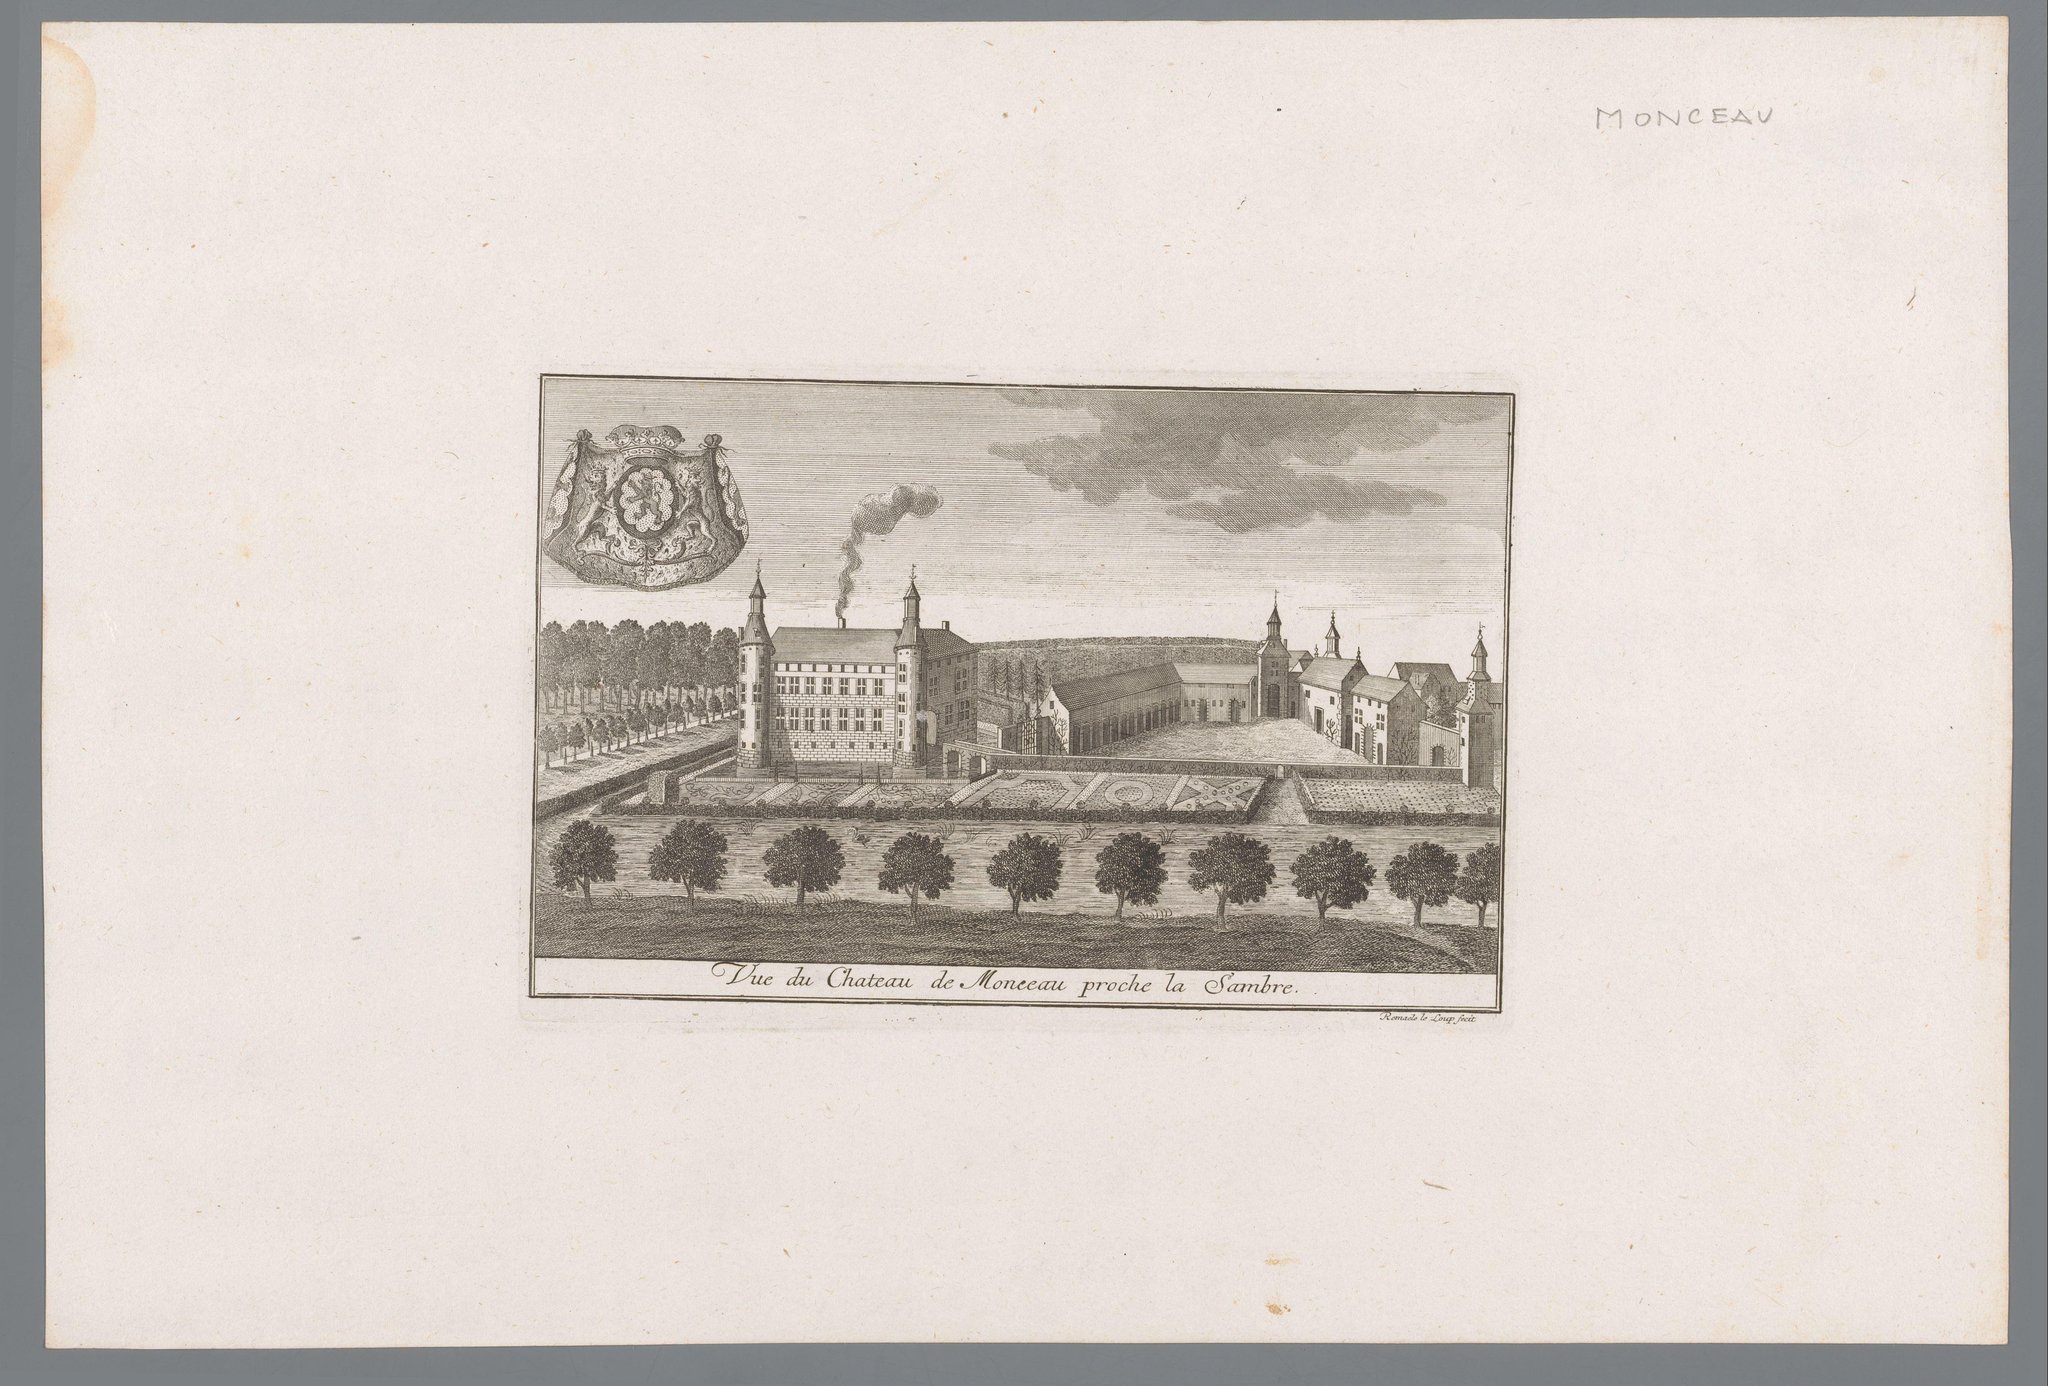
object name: print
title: Gezicht op het kasteel van Monceau-sur-Sambre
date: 1738-1744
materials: paper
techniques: engraving, etching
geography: liège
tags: castle, landscape with tower or castle, henegouwen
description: Prent uit: Johanne de Saumery, Alexandre de et al. Les délices du païs de Liège, ou description géographique, topographique et chorographique des monumes sacrés et profanes (...). 5 dln. Luik: Everard Kints, 1738-1744, dl. 2, p. 339.